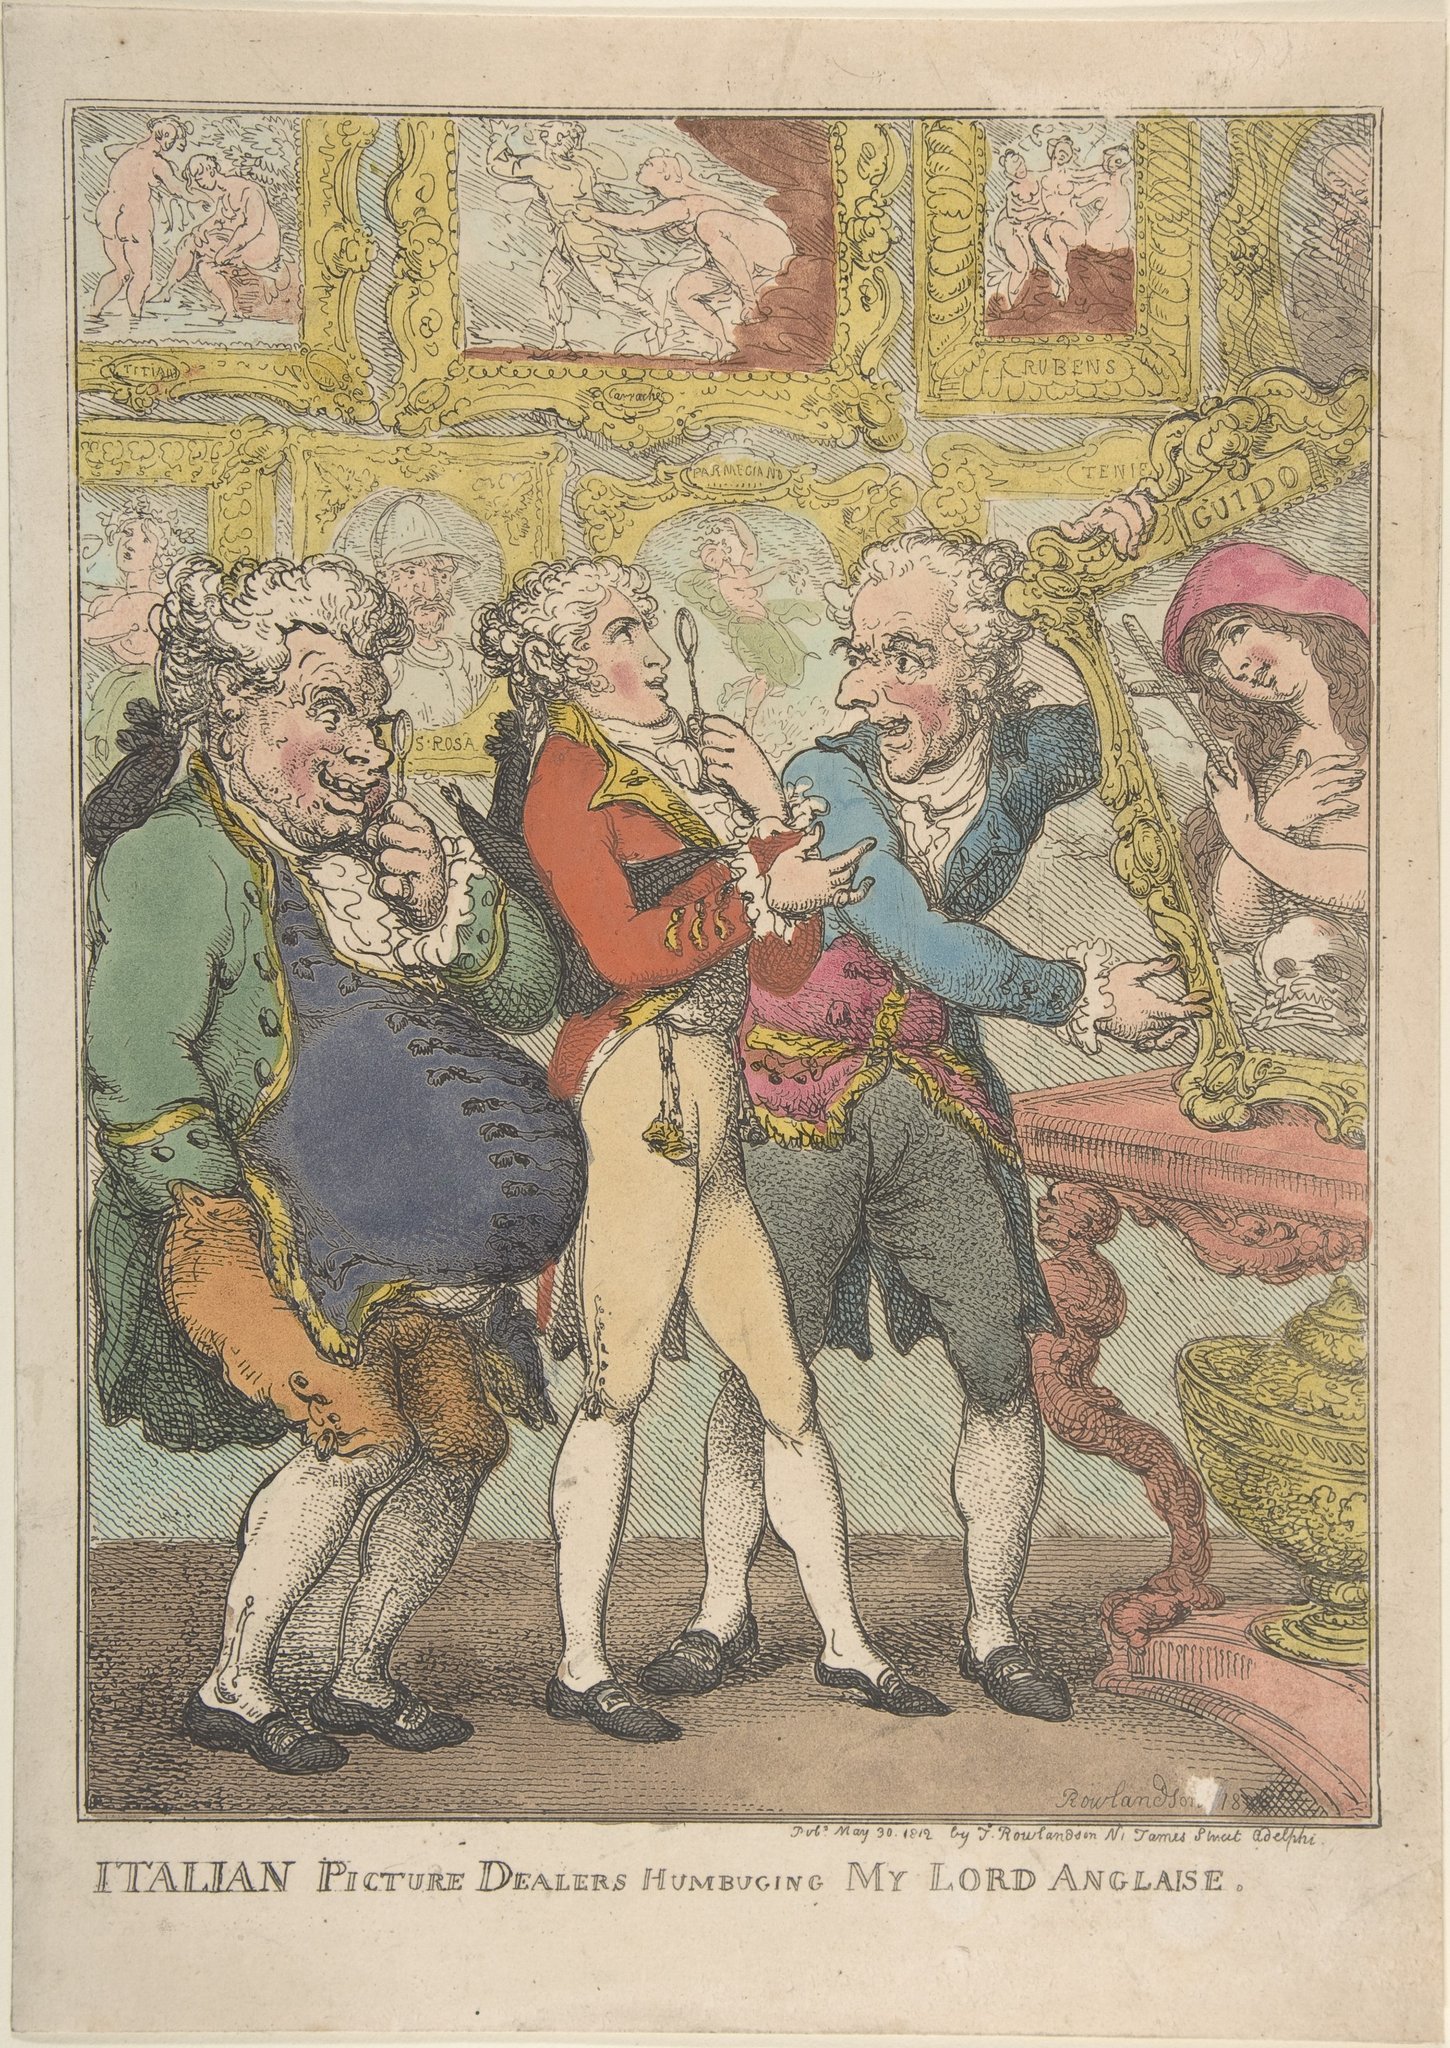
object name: print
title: Italian Picture Dealers Humbugging My Lord Anglaise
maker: thomas rowlandson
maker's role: artist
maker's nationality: british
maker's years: 1757-1827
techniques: etching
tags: men,working